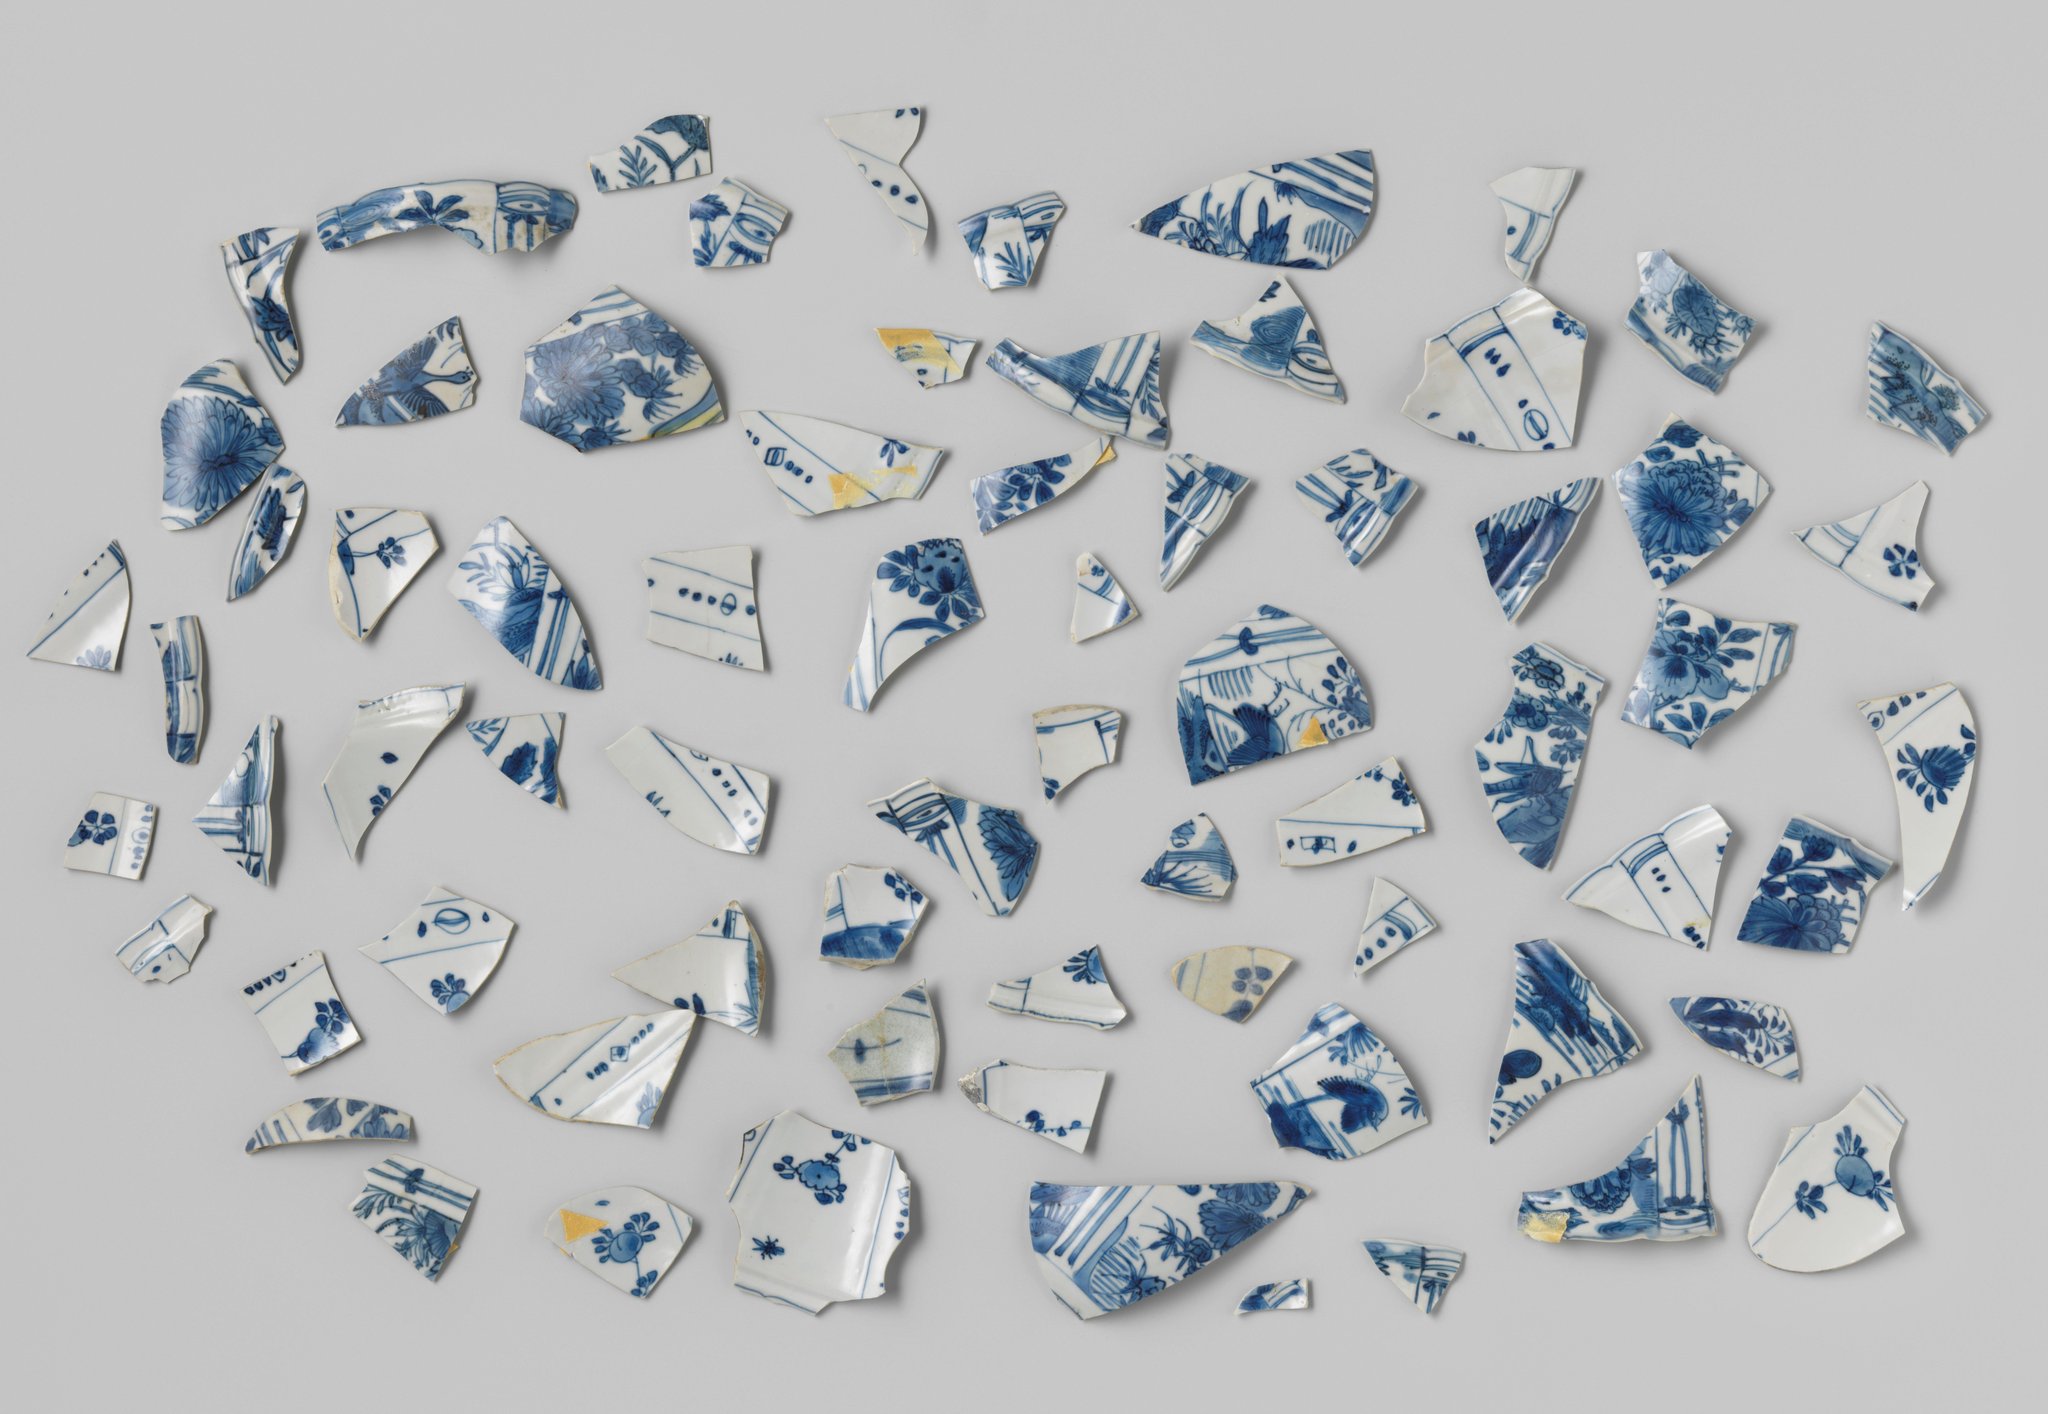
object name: kraaikop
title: Scherven van kraaikoppen uit V.O.C.-schip de 'Witte Leeuw'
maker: Anonymous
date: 1613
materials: bone china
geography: jingdezhen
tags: verenigde oostindische compagnie, sint-helena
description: A high bowl. The inside decorated with flower- and fruit-sprays. The exterior with flowers, a cicada and birds.